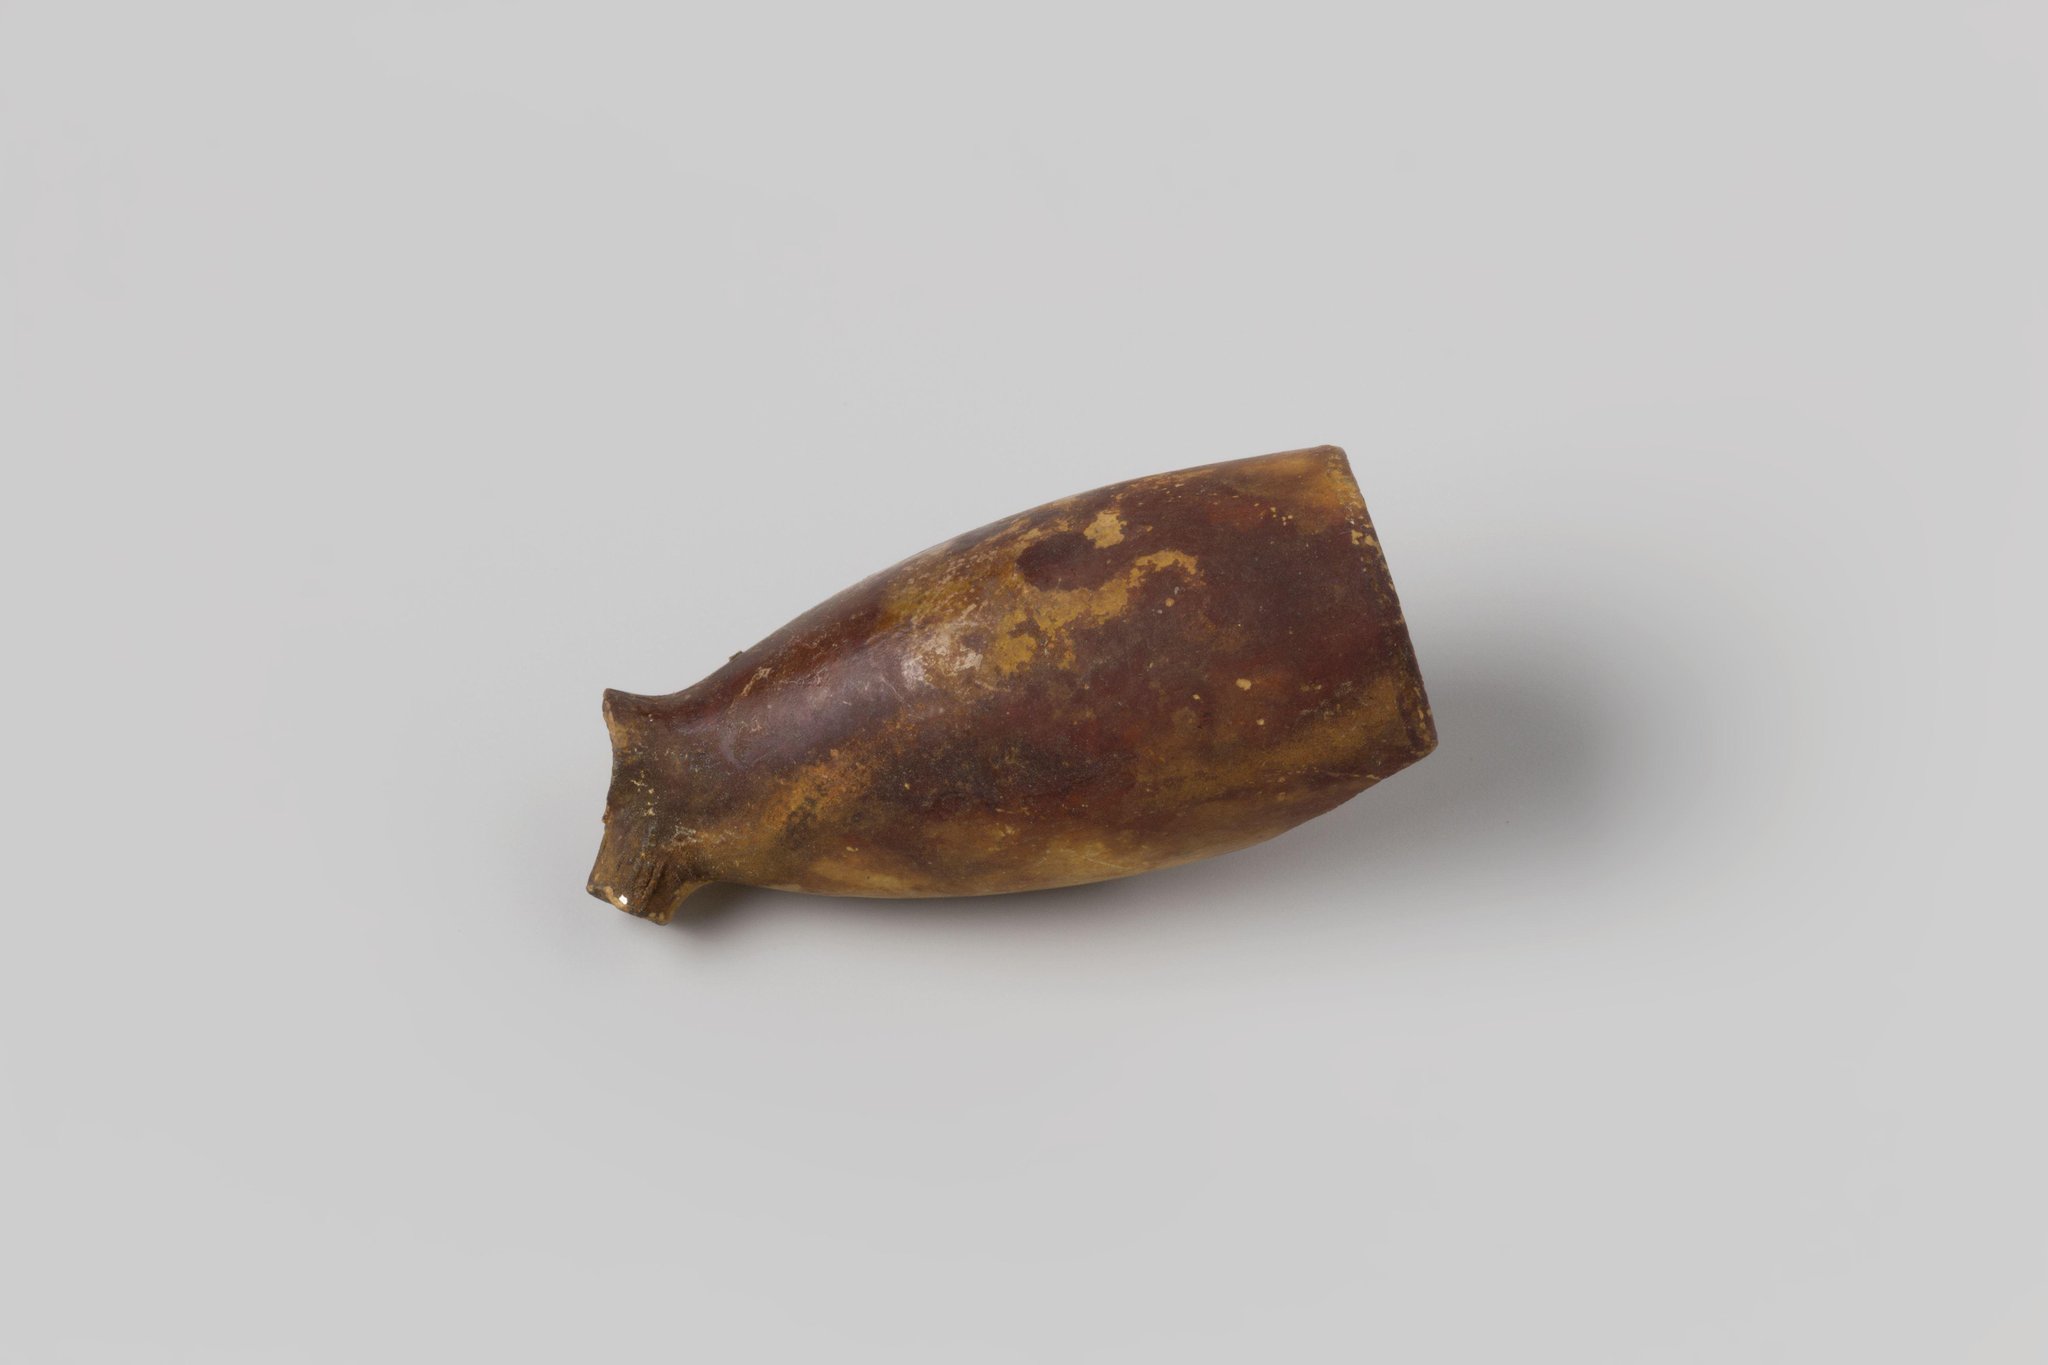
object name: pipe bowl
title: Fragment pijpenkop uit het wrak van de Oost-Indiëvaarder Hollandia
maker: Anonymous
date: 1700-1743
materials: clay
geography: netherlands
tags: verenigde oostindische compagnie, hollandia (schip), annet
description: Pipe, bowl, heelmark: coat of arms of the city of Amsterdam; fragm, 2hsm1,2.